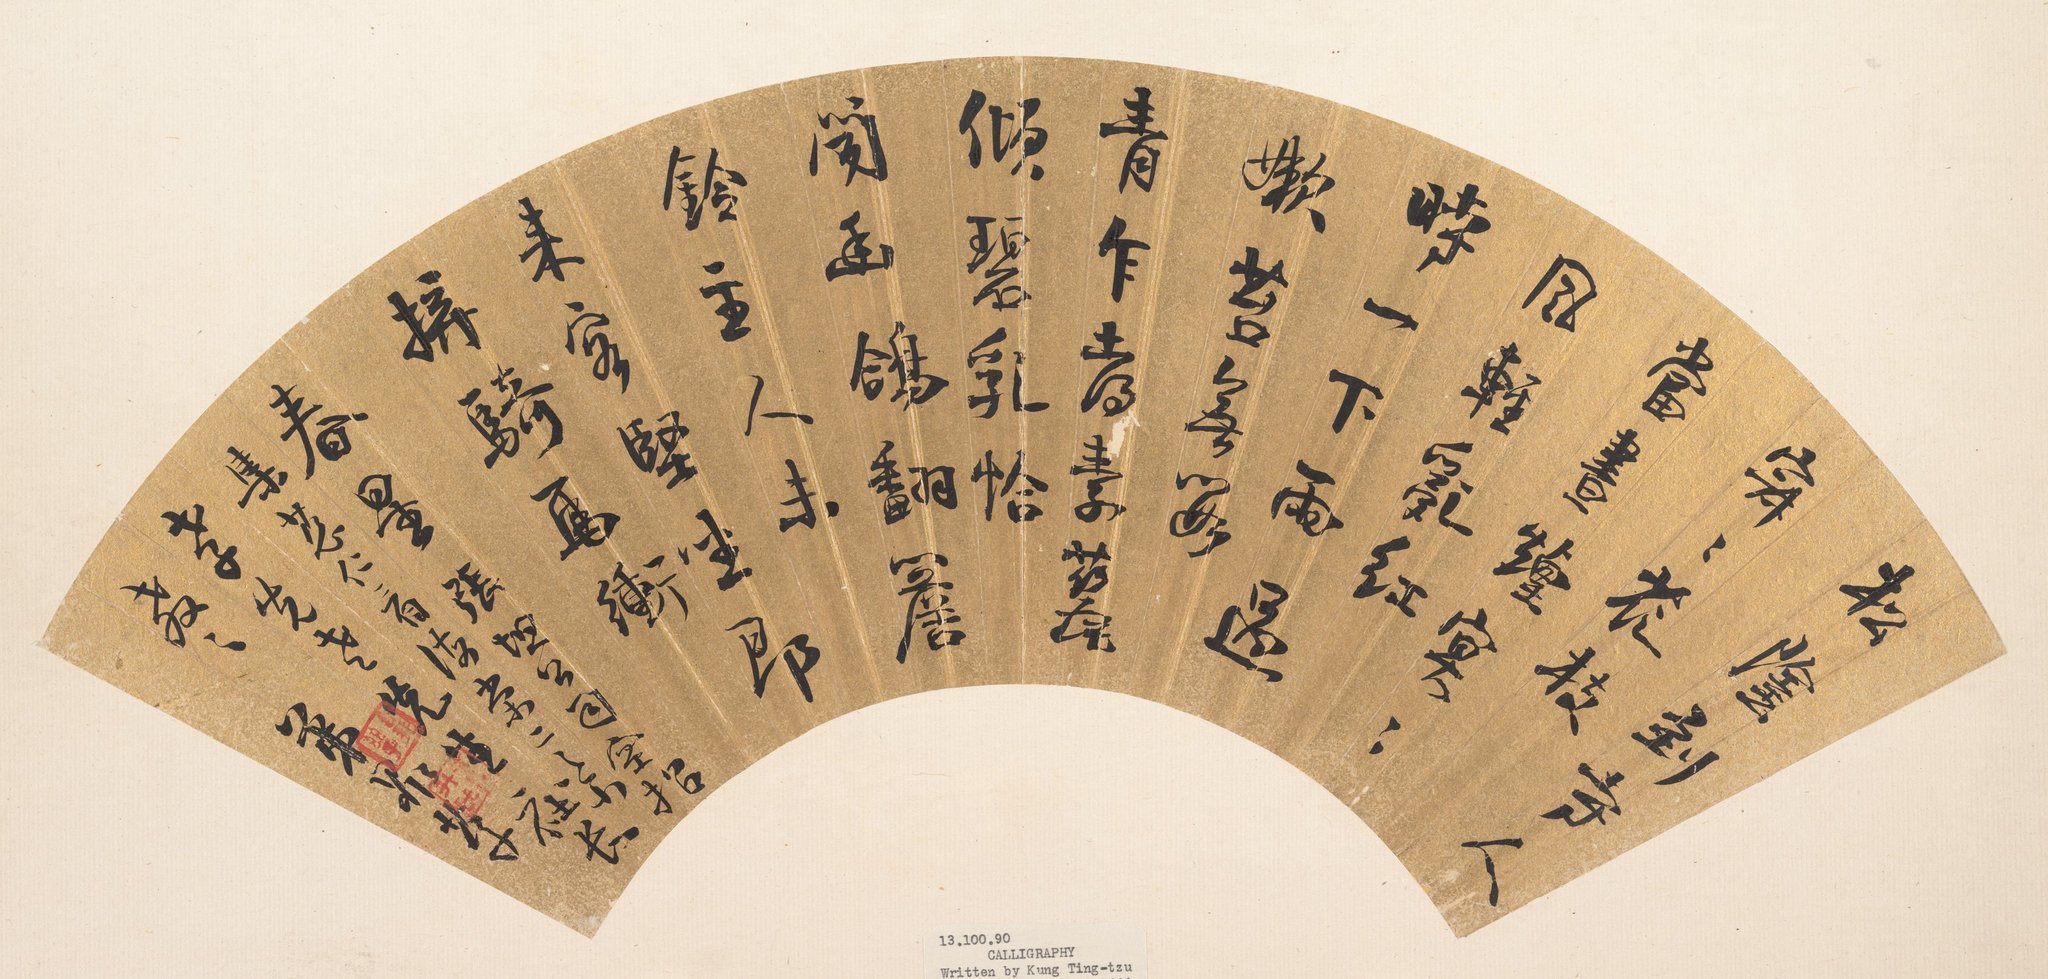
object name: folding fan mounted a an album leaf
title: Calligraphy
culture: chinese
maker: gong dingzi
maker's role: calligrapher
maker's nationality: chinese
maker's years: 1615-1673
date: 1368-1644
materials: gold, ink, paper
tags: calligraphy